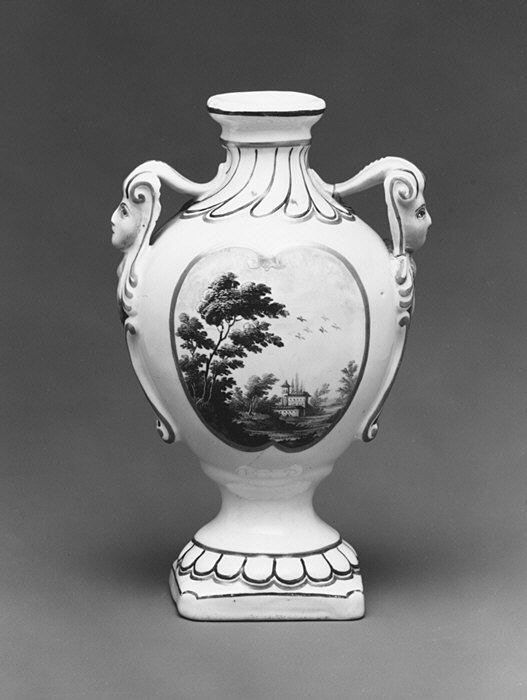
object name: vase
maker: doccia porcelain manufactory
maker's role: manufactory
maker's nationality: italian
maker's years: 1737-1896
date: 1760-1770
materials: hard paste porcelain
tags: houses,faces,trees